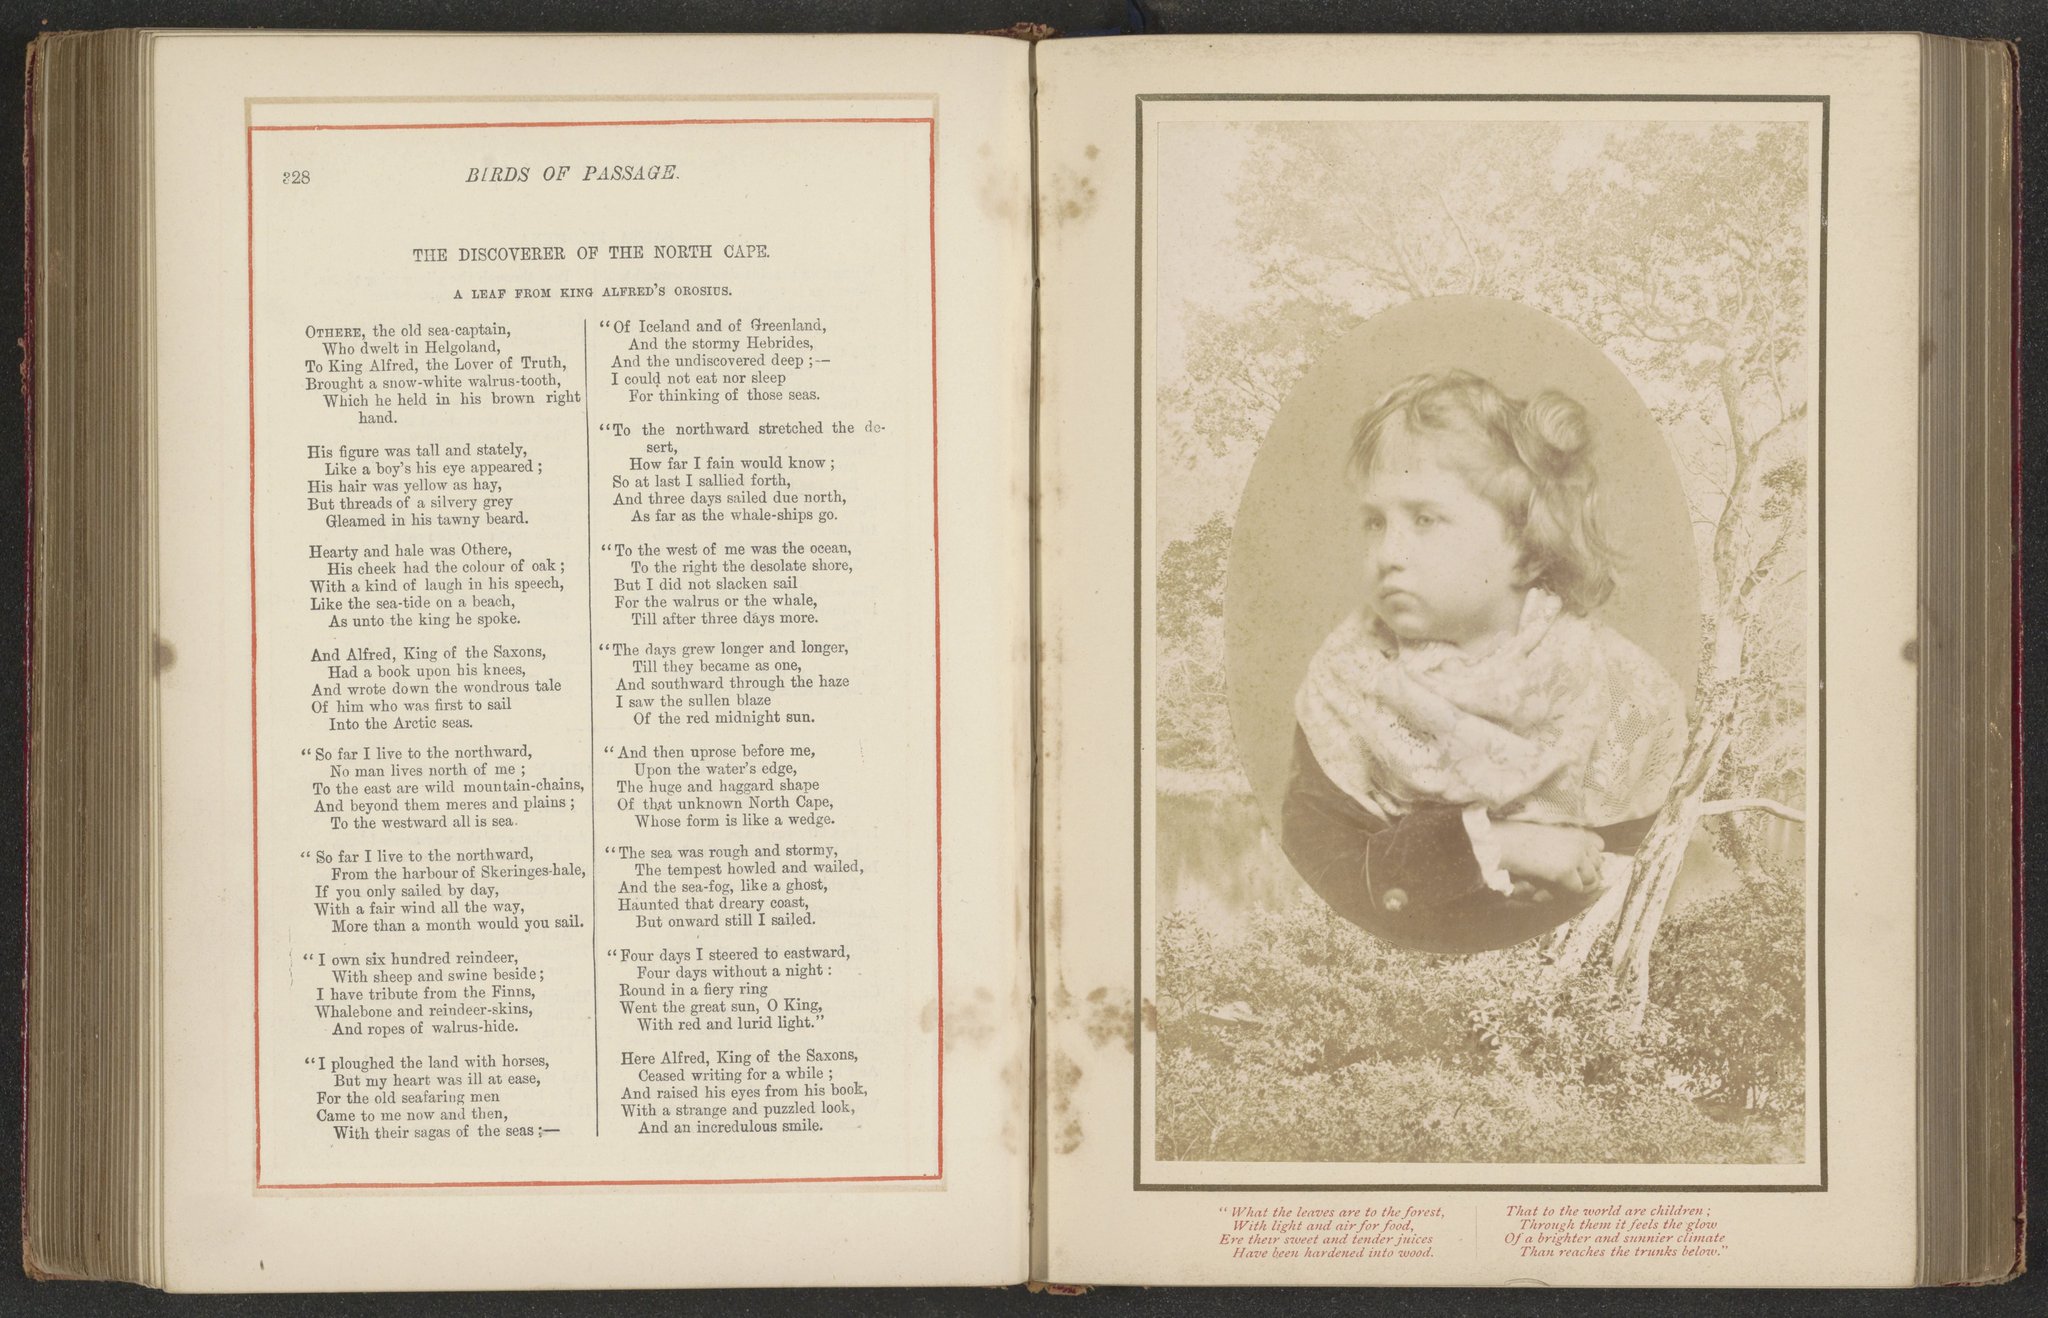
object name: page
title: Portret van een onbekend meisje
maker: john payne jennings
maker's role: fotograaf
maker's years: 1843-1926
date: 1867-1877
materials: photographic support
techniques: albumen print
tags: forest, wood, child (at home) - aa - girl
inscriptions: inscription: ‘"What the leaves are the forest, Whith light and air for food (...)’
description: Portret geplaatst voor een foto van een bos en water.